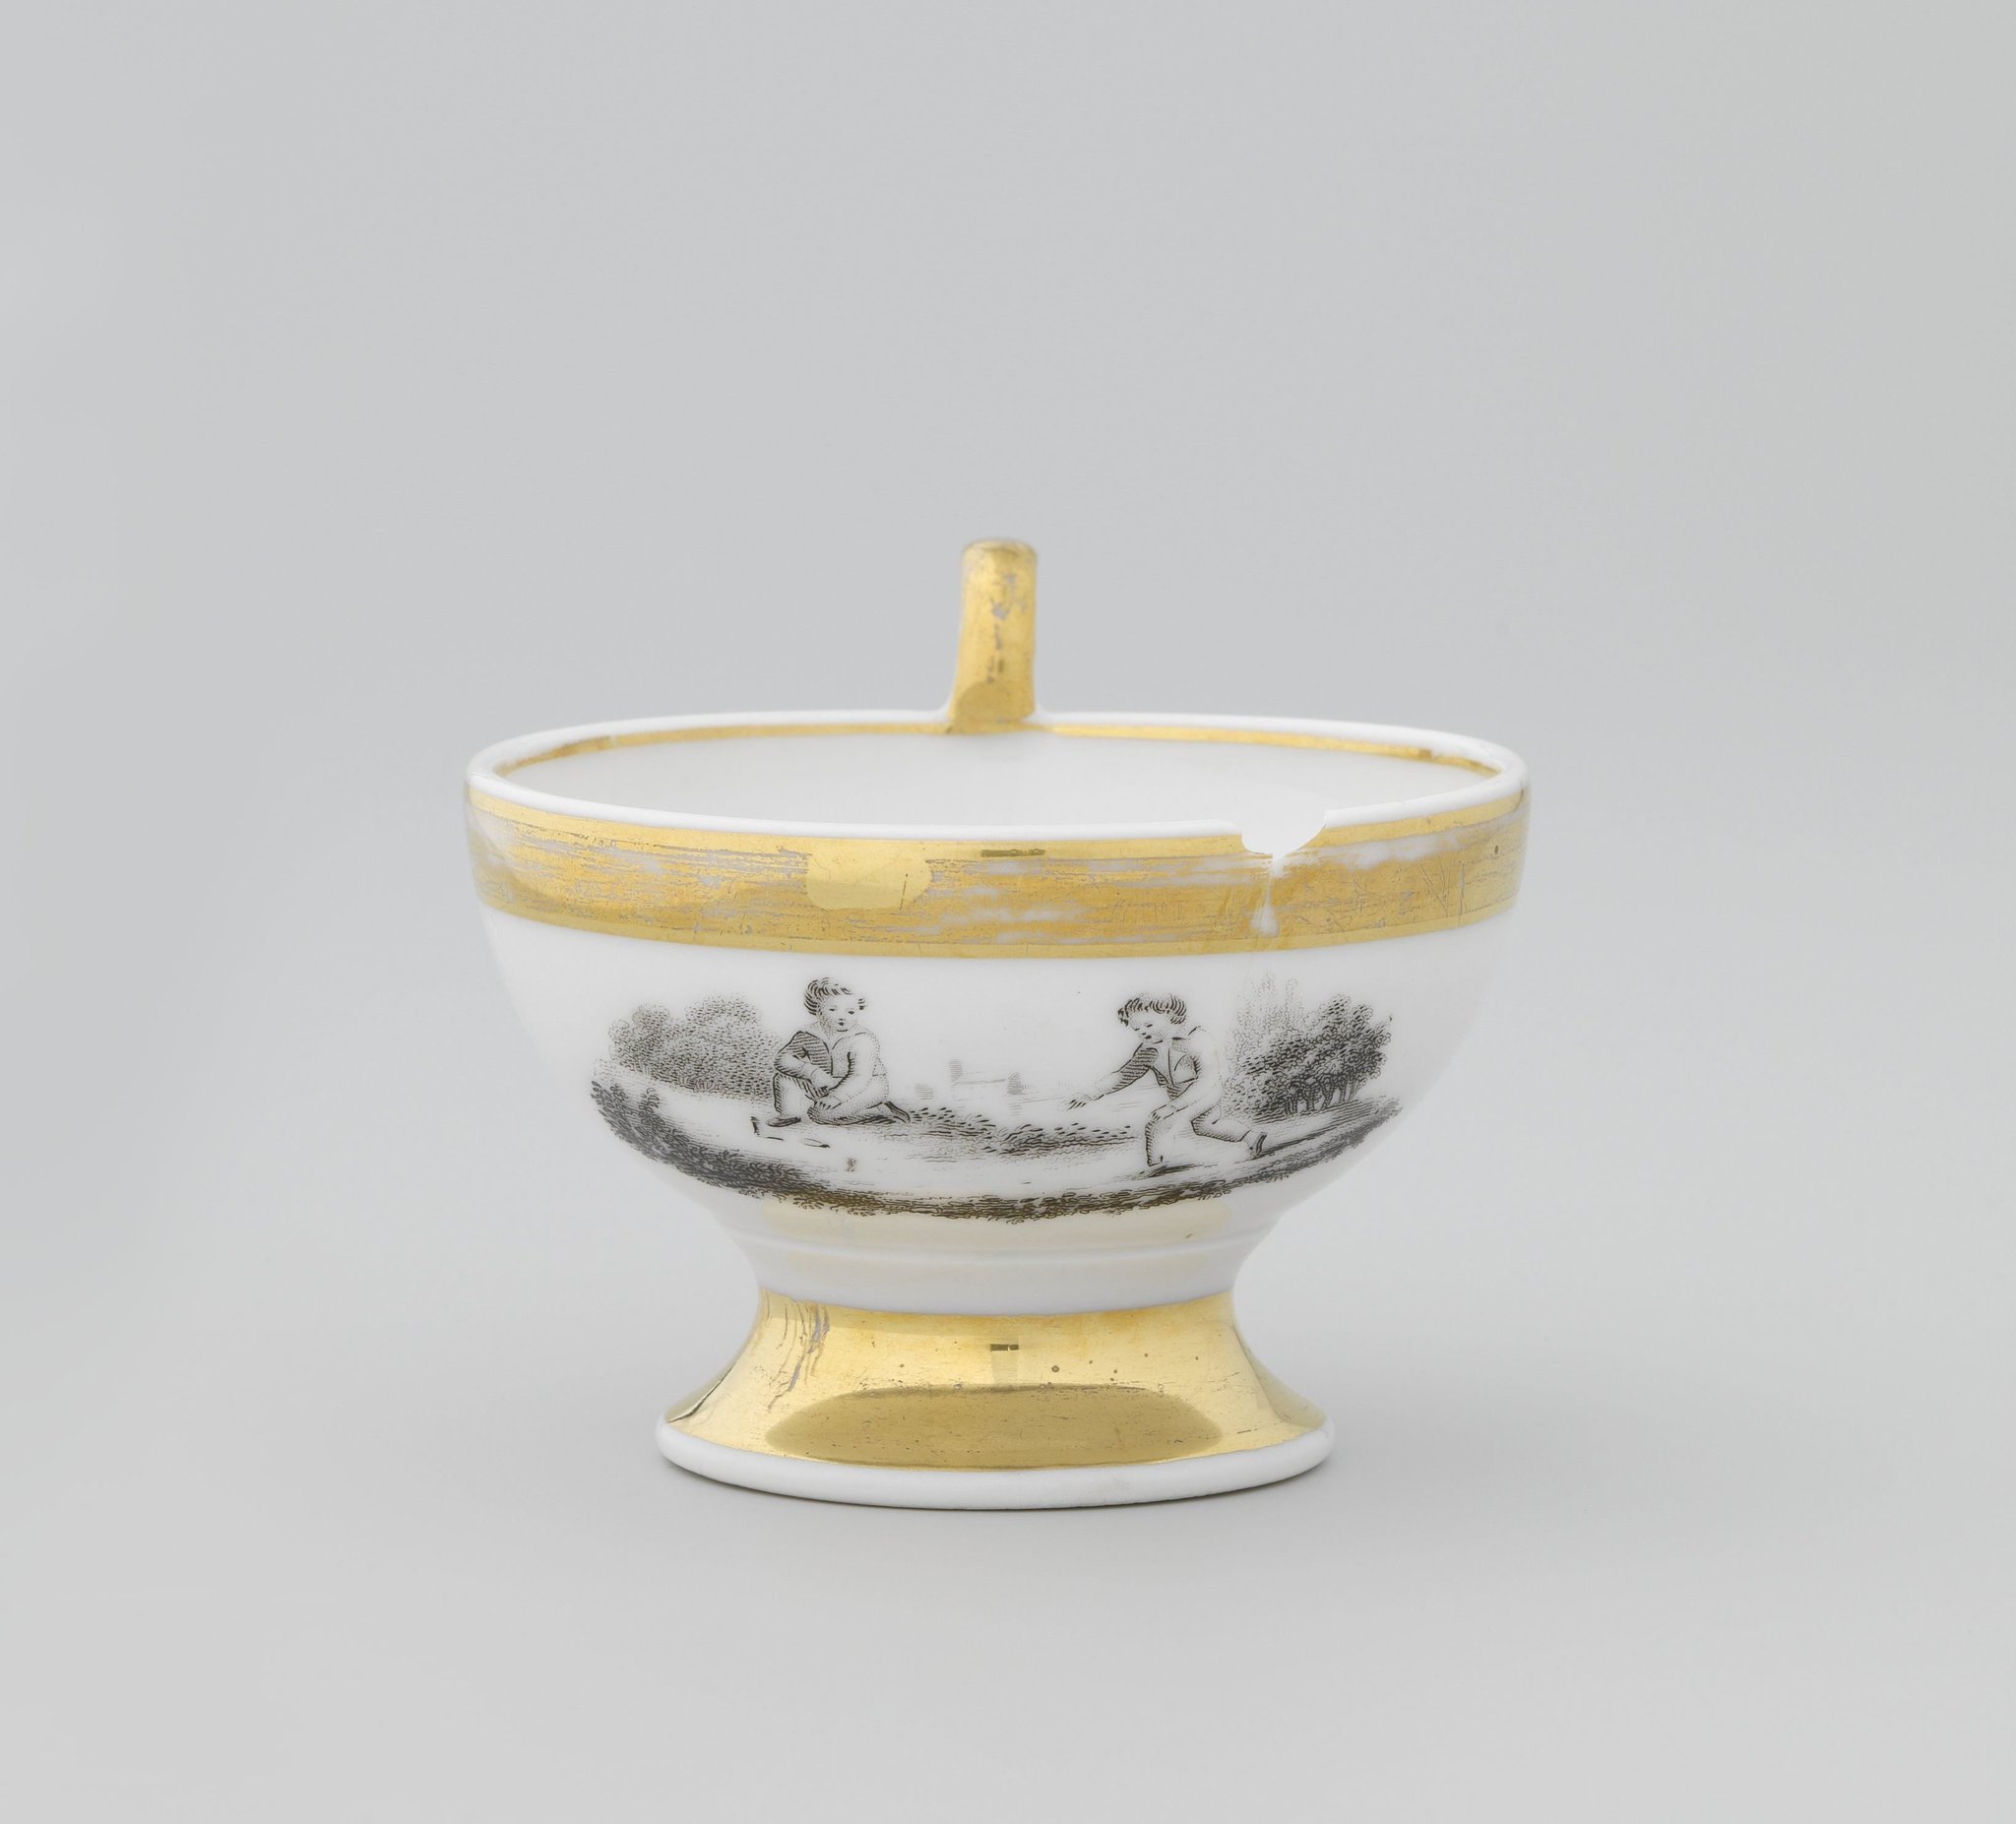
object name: cup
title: Cup with different figures in a landscape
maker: Anonymous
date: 1850-1899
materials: glaze, gold, paint, porcelain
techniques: firing, forming, gilding, turning, vitrification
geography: europe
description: Kop van porselein, op hoge voet en met vraagtekenvormig oor. Behoort tot een serie van twaalf kop en schotels. Langs de mondrand een brede gouden bies, het oor is verguld. De kop is versierd met een drukdecor in zwart, voorstellende spelende kinderen of volwassenen in een landschap.